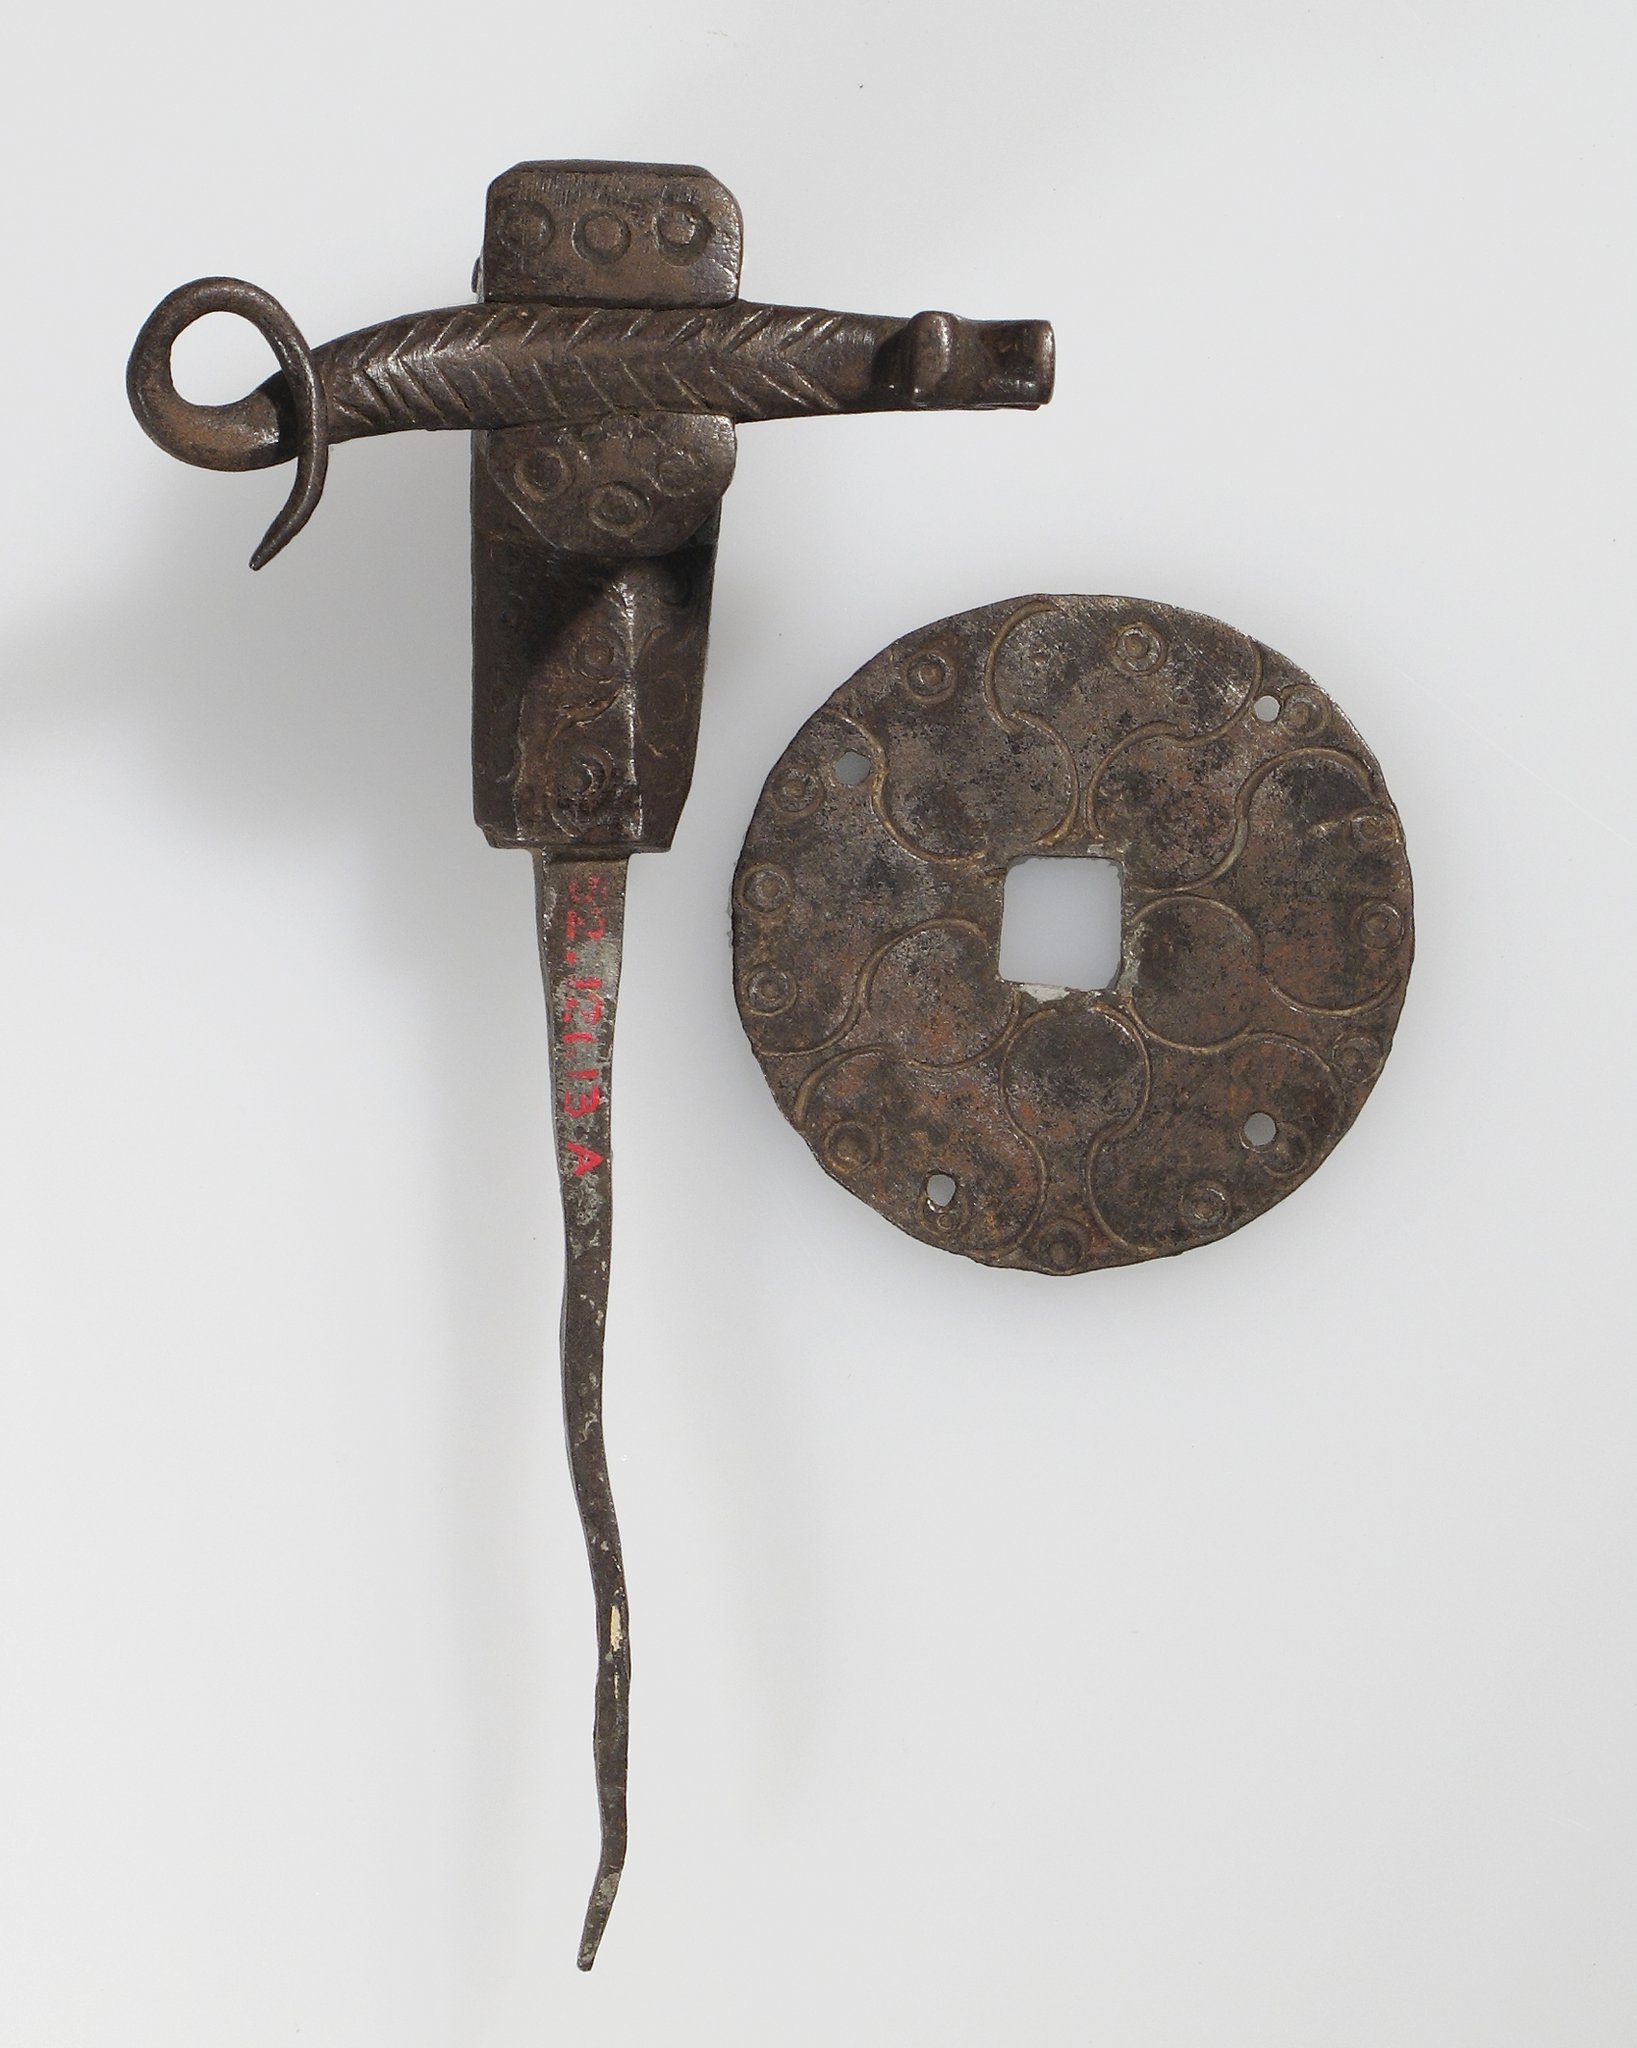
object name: stud and plate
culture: european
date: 1401-1600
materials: iron